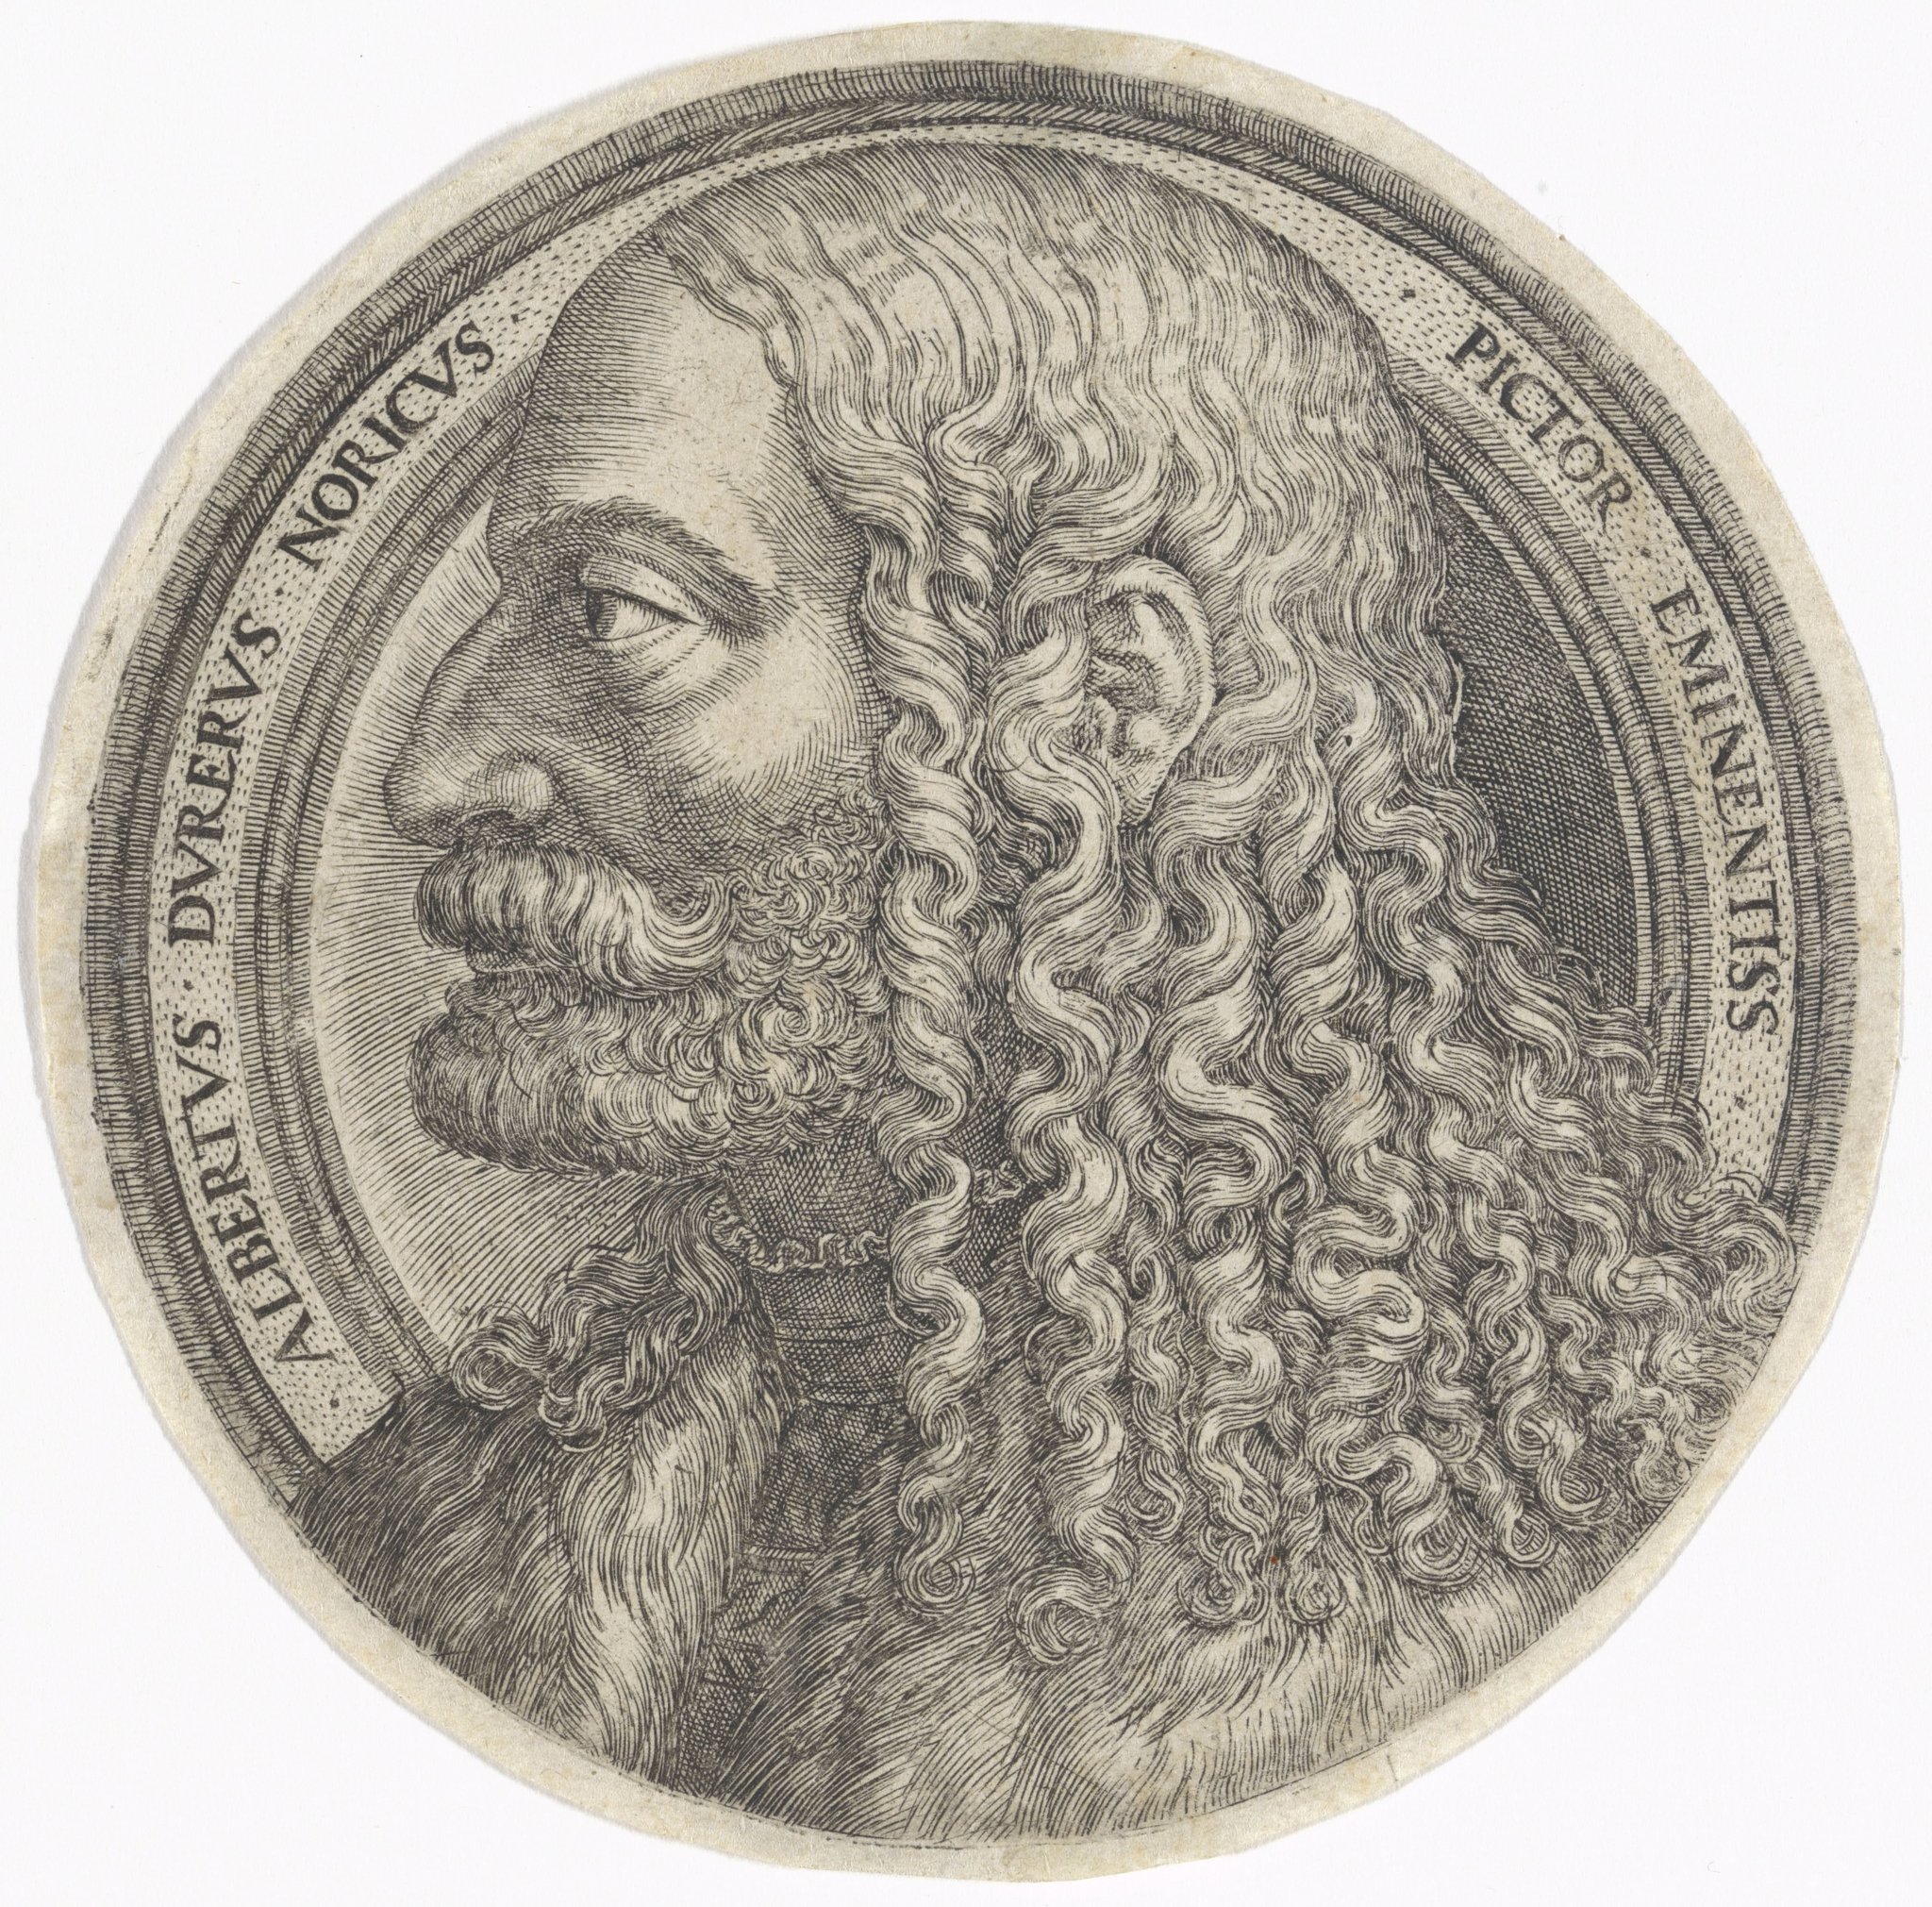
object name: print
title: Portret van Albrecht Dürer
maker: lambertus suavius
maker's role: print maker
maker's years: 1514-1564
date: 1520-1567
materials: paper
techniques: engraving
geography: southern netherlands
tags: painter, draughtsman, albrecht dürer, portrait, self-portrait of painter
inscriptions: collector's mark: Lugt 2228